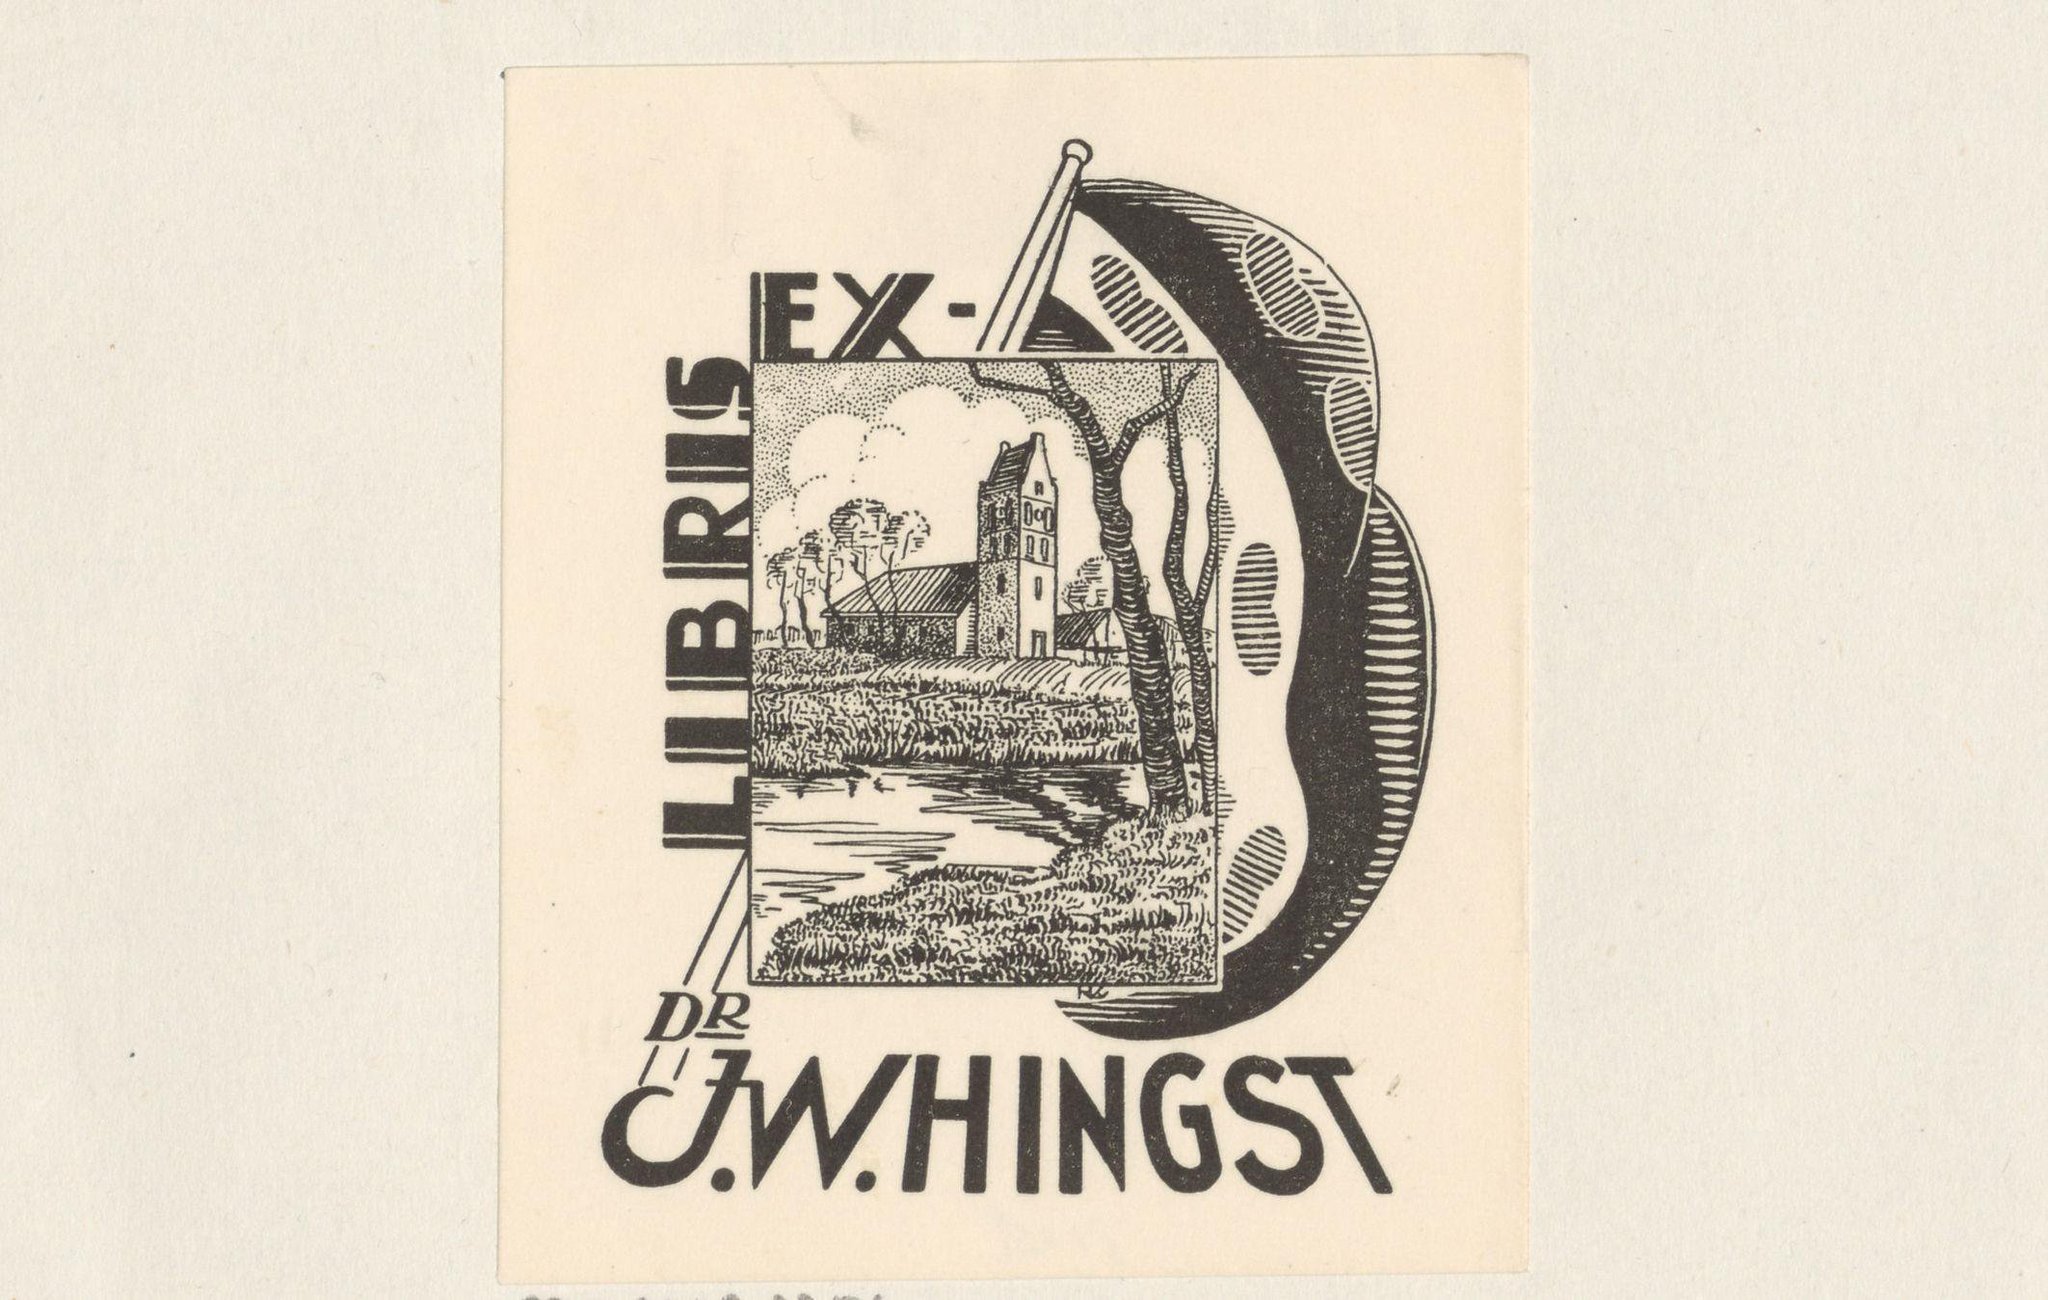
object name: bookplate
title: Ex libris van Dr. J.W. Hingst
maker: Anonymous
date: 1927-1978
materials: paper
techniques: printing block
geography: netherlands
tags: the christian churches, meadow, pasture, flag, colours (as symbol of the state, etc.)